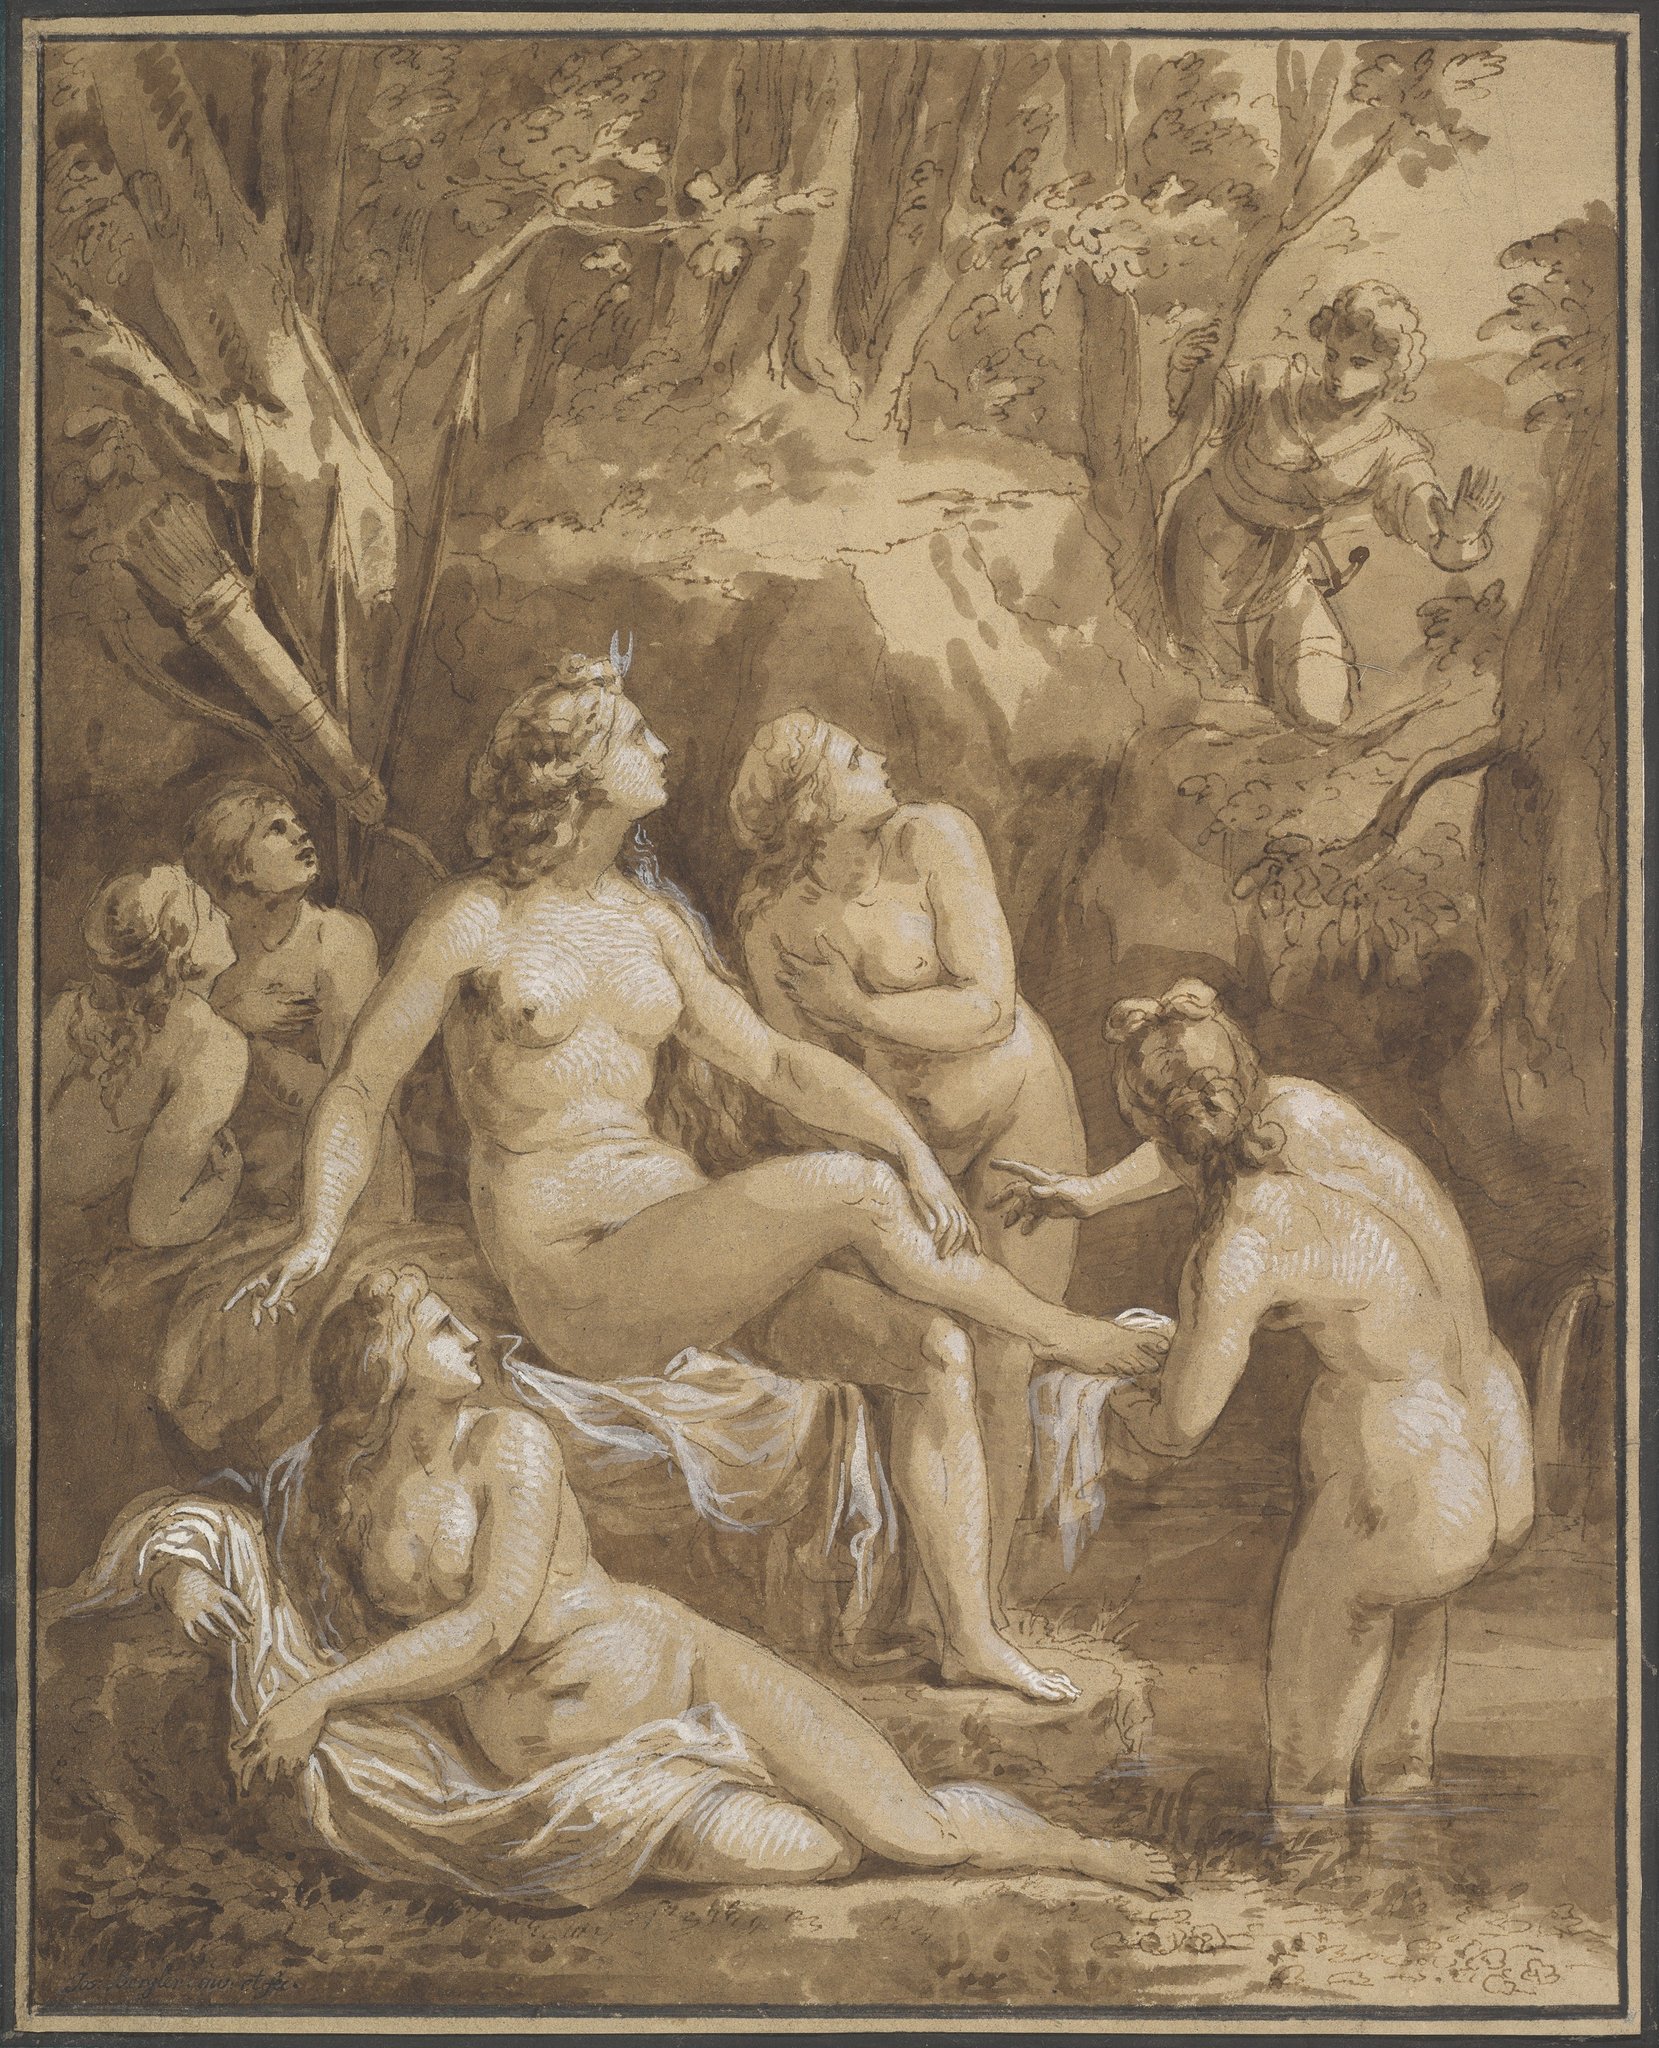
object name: drawing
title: Diana and Actaeon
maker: joseph bergler the younger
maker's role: artist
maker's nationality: austrian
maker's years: 1753-1829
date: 1767-1833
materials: gouache, ink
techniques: brush, heightening, pen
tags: female nudes,actaeon,diana